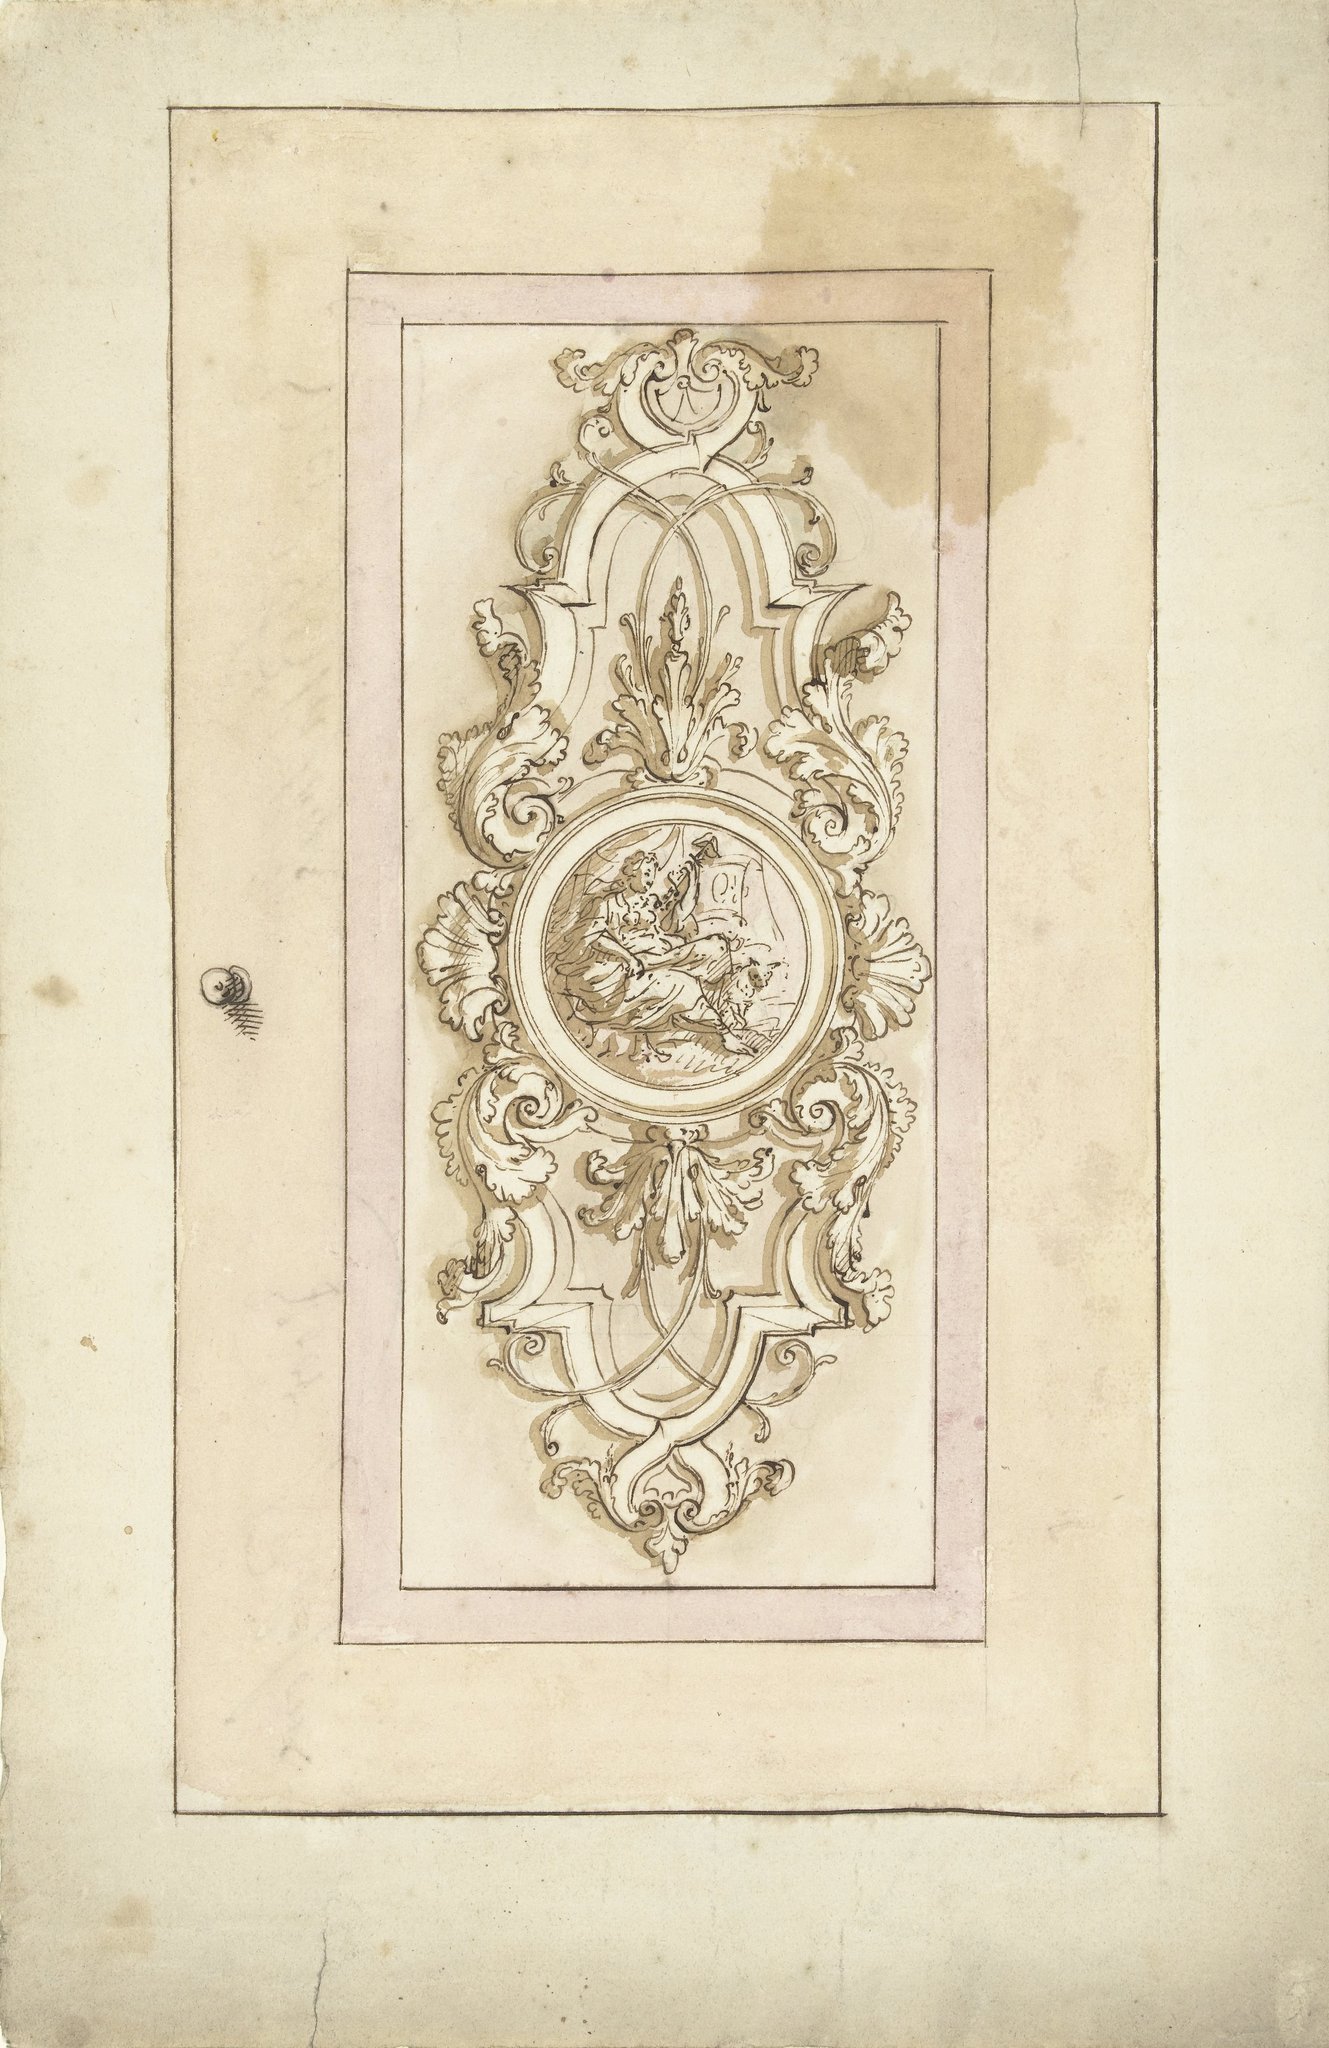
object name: drawing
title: Ornamentaal ontwerp voor een deurpaneel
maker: elias van nijmegen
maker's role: draughtsman, painter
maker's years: 1667-1755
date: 1677-1755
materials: ink, paper, pencil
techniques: brush, pen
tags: door